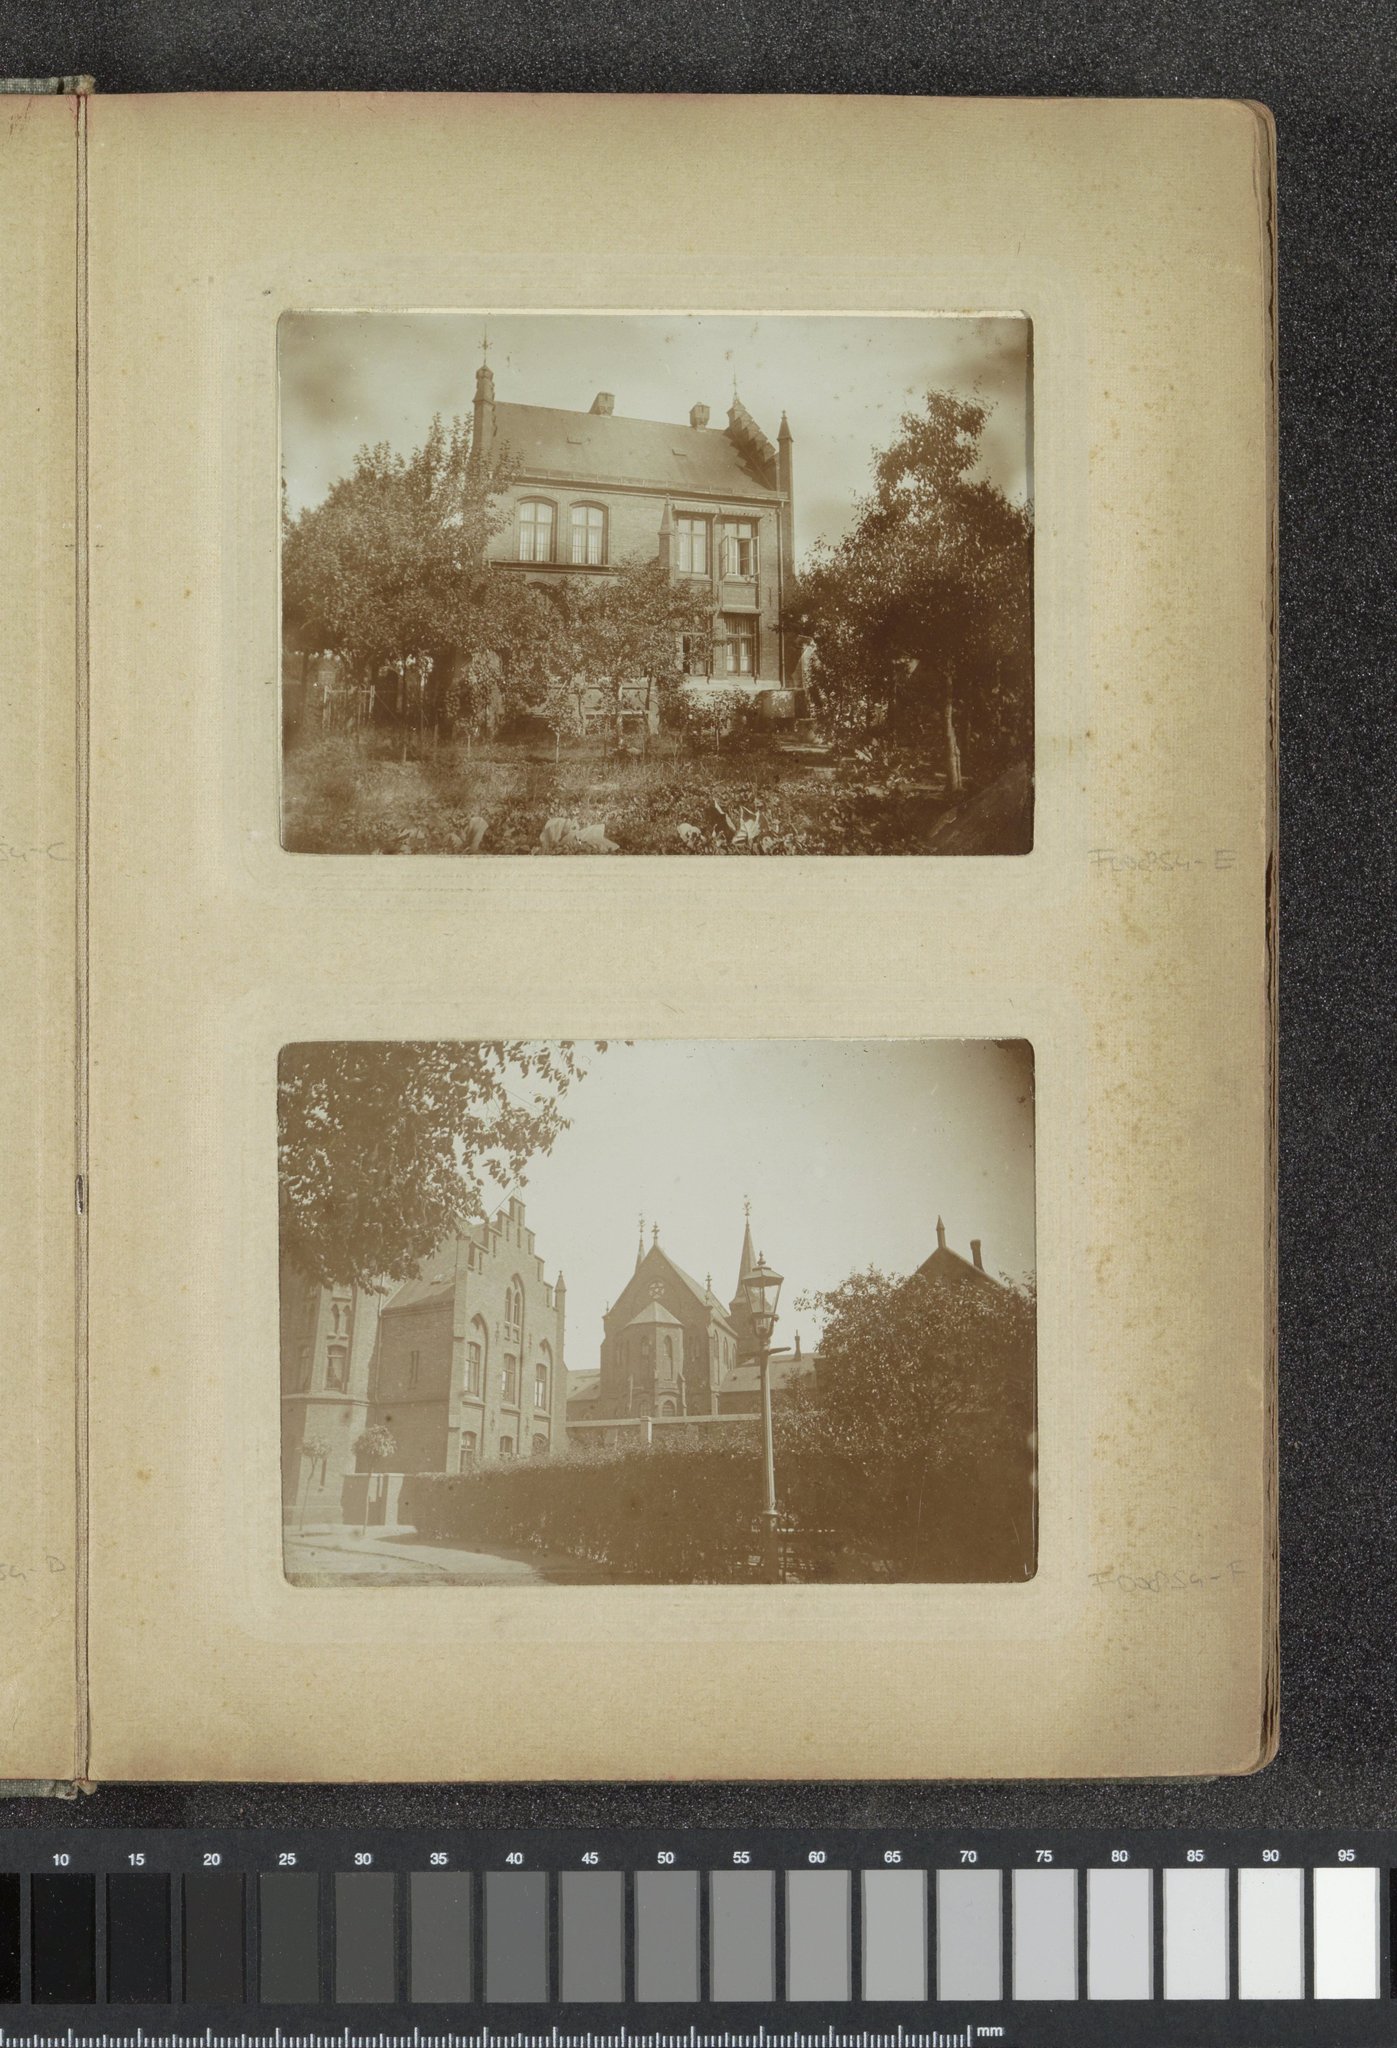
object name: photograph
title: Woning met tuin behorend bij de gevangenis van Oslebshausen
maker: Anonymous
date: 1890-1910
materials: cardboard, paper, photographic support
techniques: collodion silver print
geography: oslebshausen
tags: garden, façade (of house or building)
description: Onderdeel van Fotoalbum van Carl Heinrich Fliegenschmidt, gevangenisdirecteur te Oslebshausen.